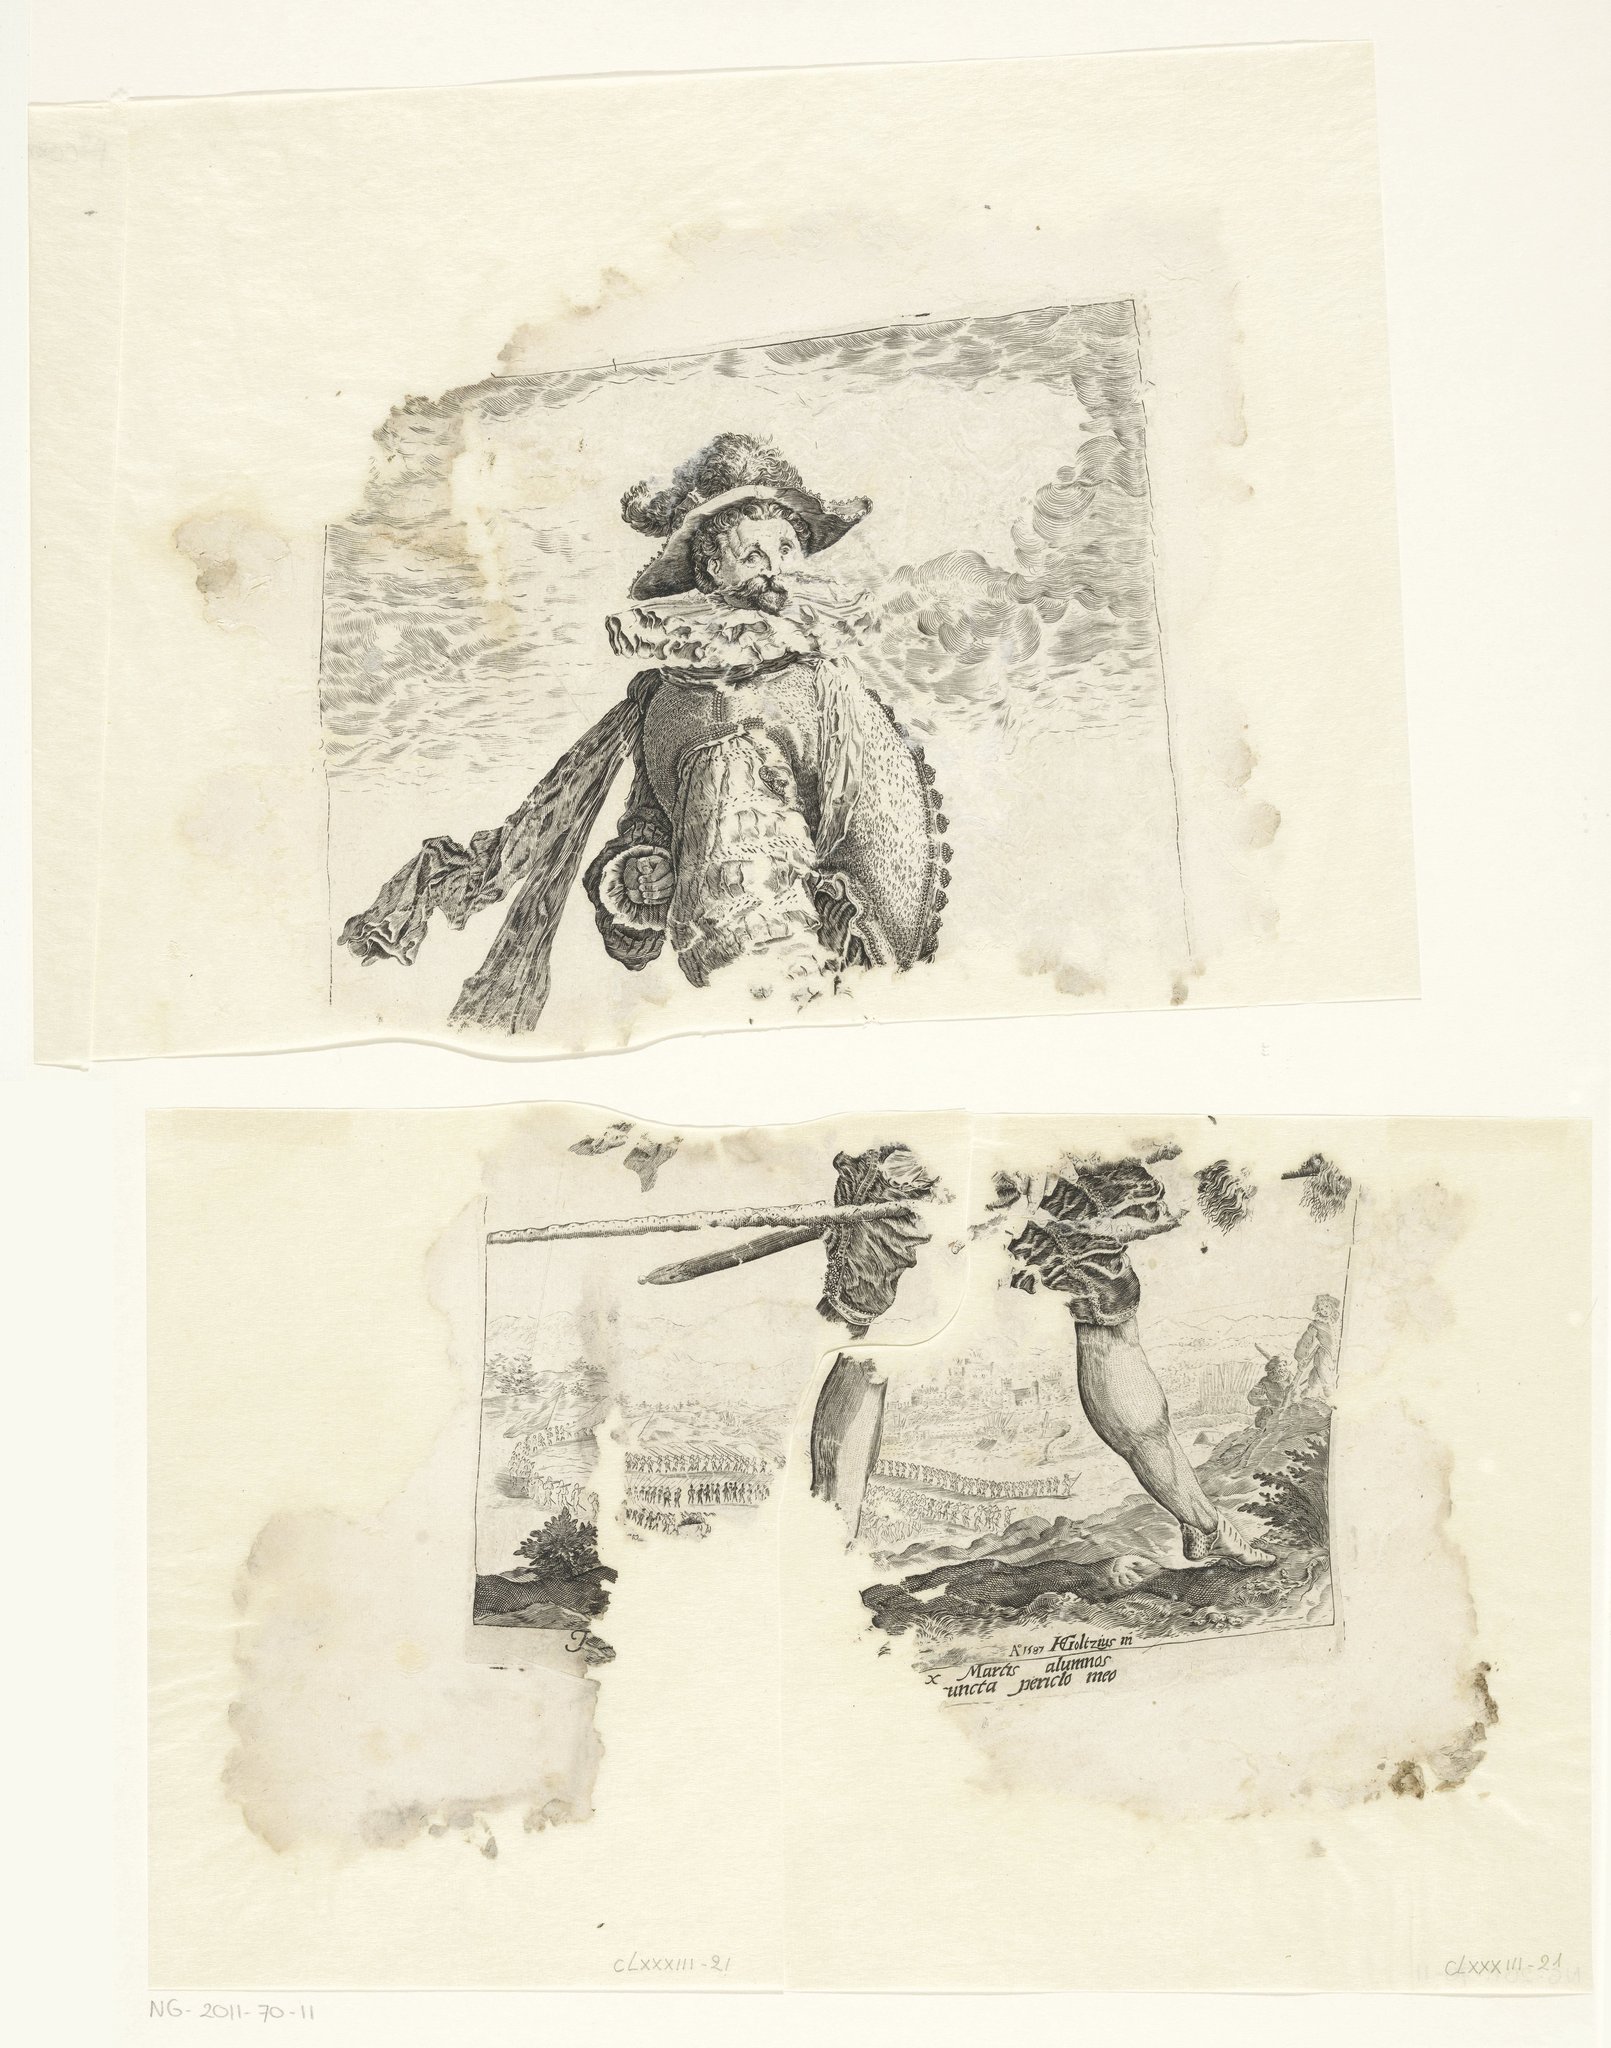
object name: print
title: Kapitein van de infanterie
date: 1587-1596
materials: paper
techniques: engraving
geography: northern netherlands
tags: officer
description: De prenten in de Nova Zembla collectie zijn tijdens een expeditie van Willem Barendsz en Jacob van Heemskerk in 1596-1597 noodgedwongen in het winterkamp, het ‘Behouden Huis’, op het eiland achtergelaten. De prenten waren in één of meerdere stapels als handelswaar meegenomen vanuit Amsterdam. Bijna drie eeuwen later, in 1871, keerde de Noor Elling Carlsen terug naar Nova Zembla en vond daar de restanten van het ‘Behouden Huis, inclusief een groot deel van de inventaris. Een deel van de prenten, in de vorm van aaneengekoekte kluiten, werd toen ook teruggevonden. De papierkluiten waren soms op meerdere plekken gebroken. Tussen 1975-1979 zijn de prenten van elkaar gescheiden. Dit leverde in totaal ca. 1000 fragmenten van ca. 400 afdrukken van ca. 150 verschillende prenten op. Voor zover mogelijk zijn de fragmenten samengevoegd en zijn de prenten gereconstrueerd.